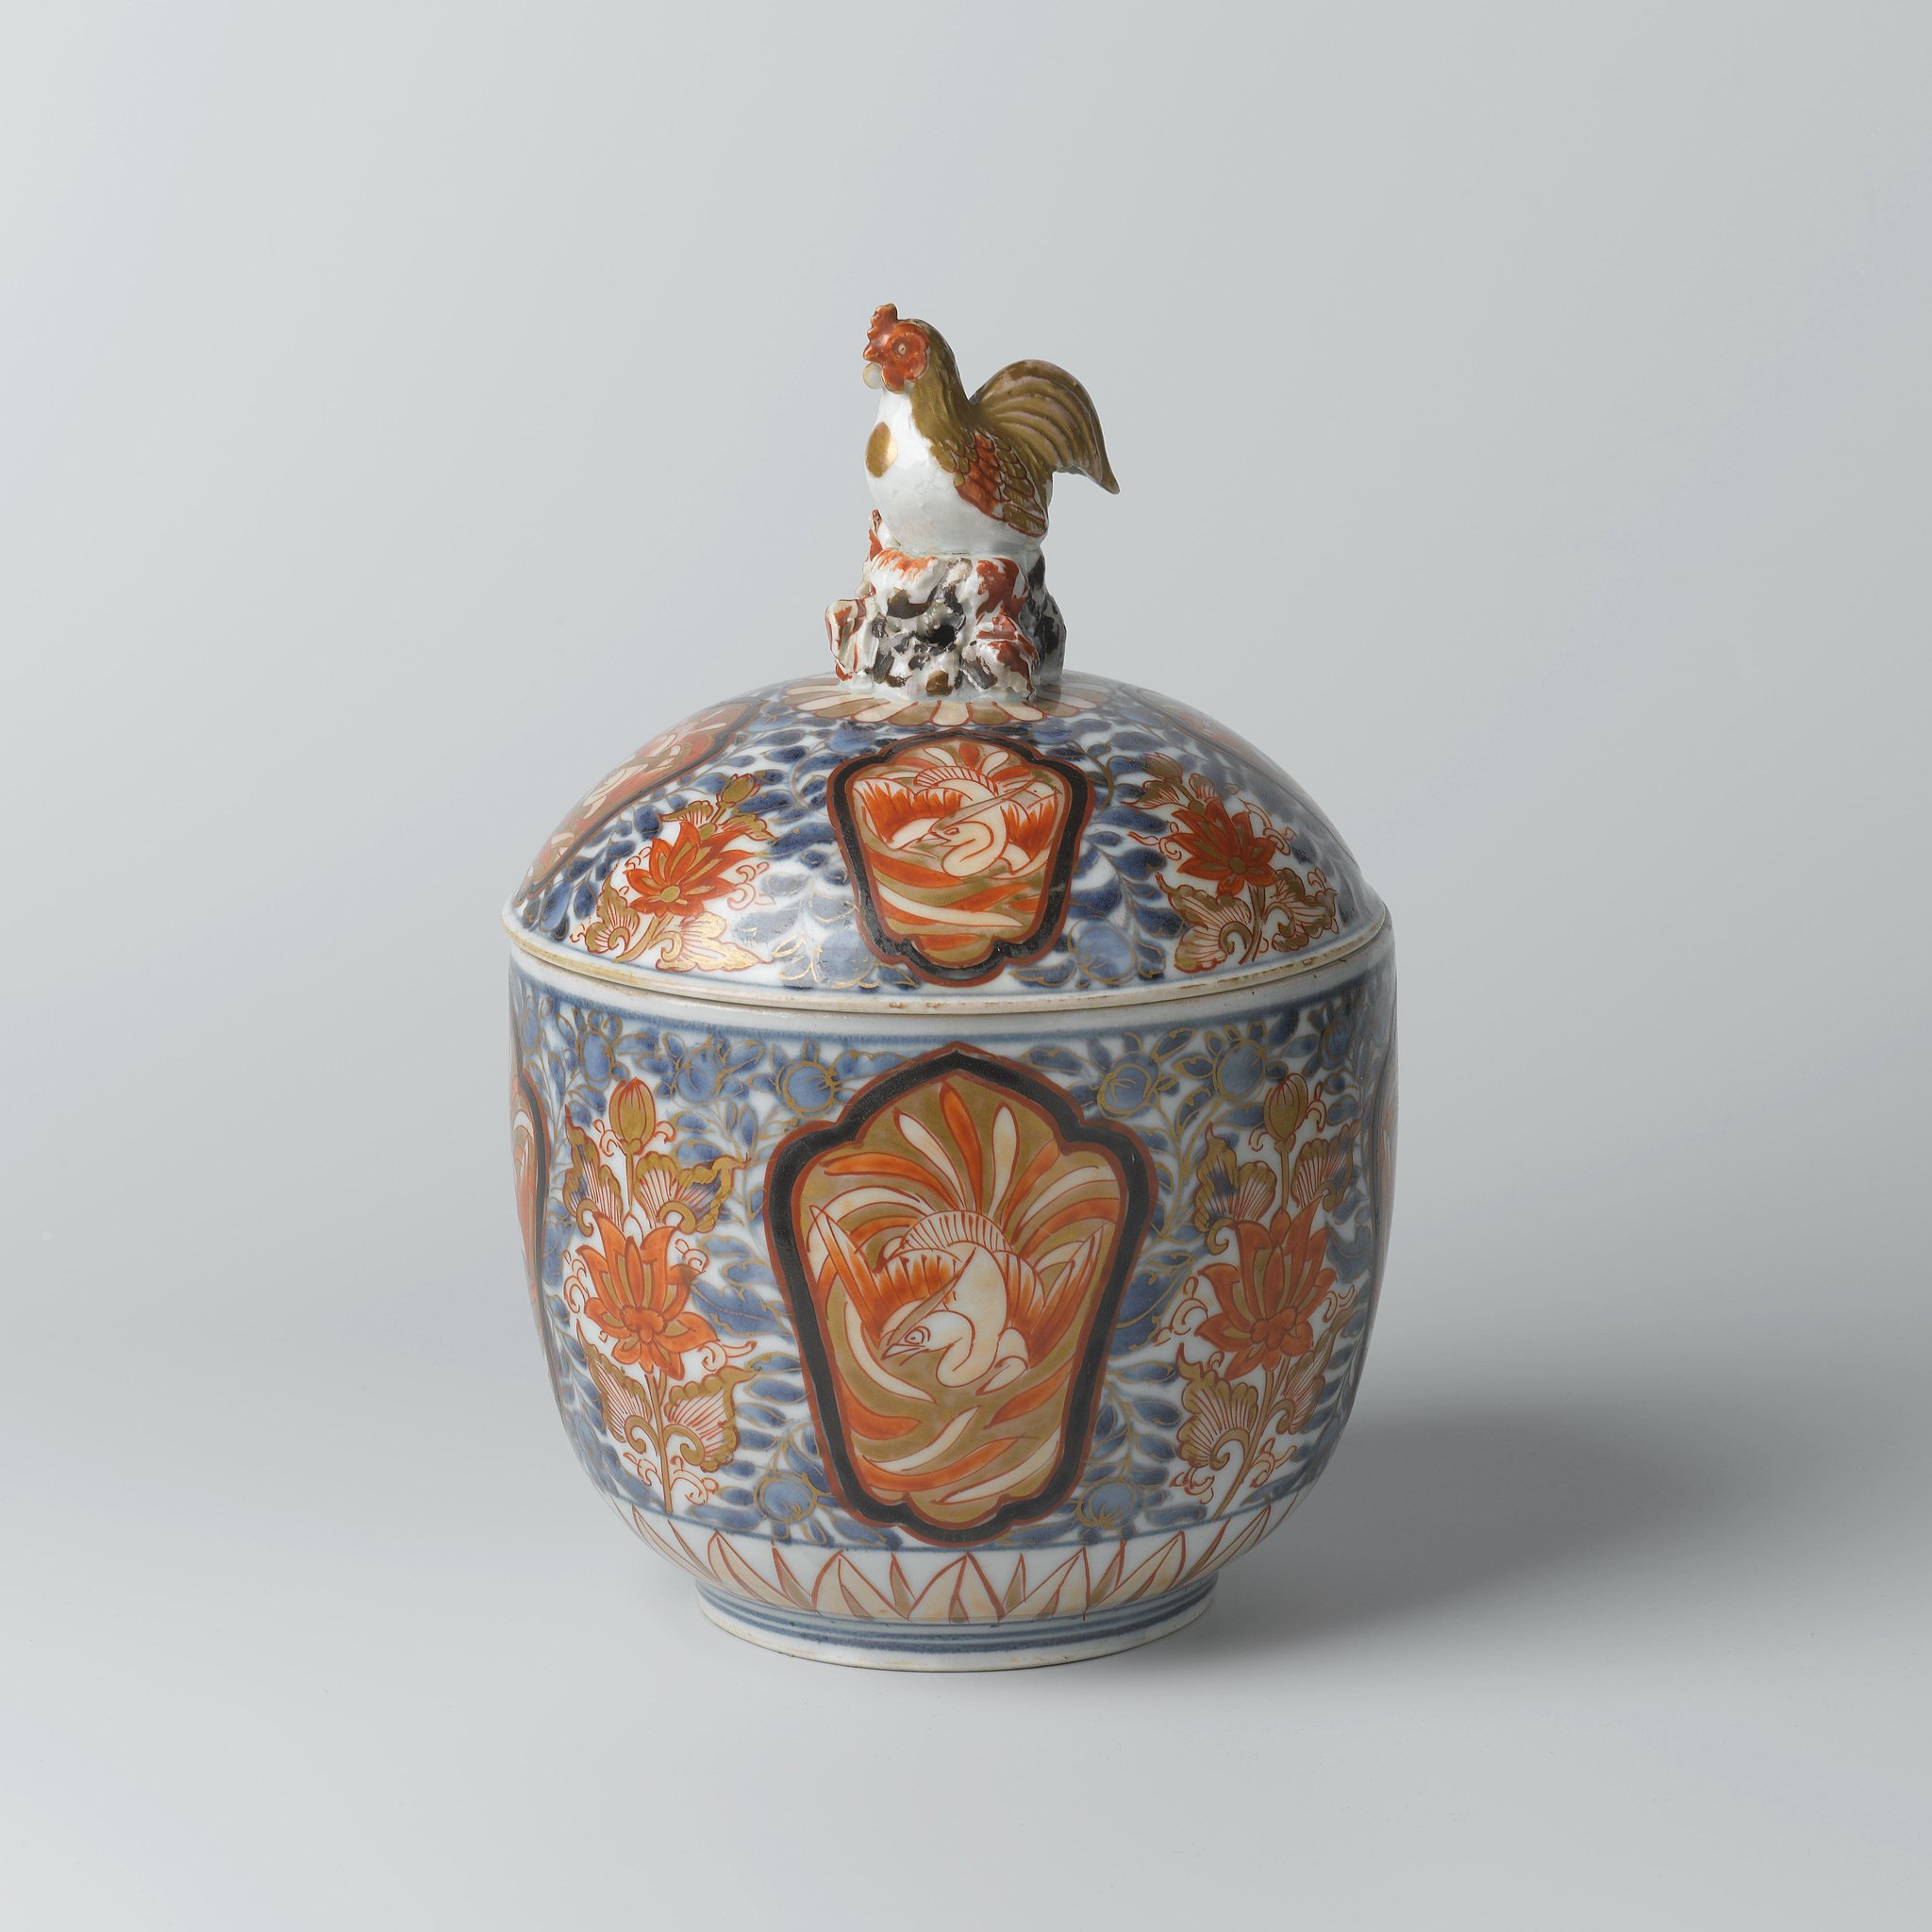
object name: covered jar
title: Covered jar with hoo-birds in panels on a ground of lotus and floral scrolls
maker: Anonymous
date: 1720-1770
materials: cobalt, glaze, gold, paint, porcelain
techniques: firing, gilding, turning, vitrification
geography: japan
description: Deksel van dekselpot van porselein, beschilderd in onderglazuur blauw en op het glazuur rood, zwart en goud. Op de buitenwand bloemranken met hierin uitgespaard afwisselend een lotusrank en een cartouche met een hoo-vogel. Rond de knop een band met puntige bladmotieven. Dekselknop in de vorm van een haan op een rots. Imari.